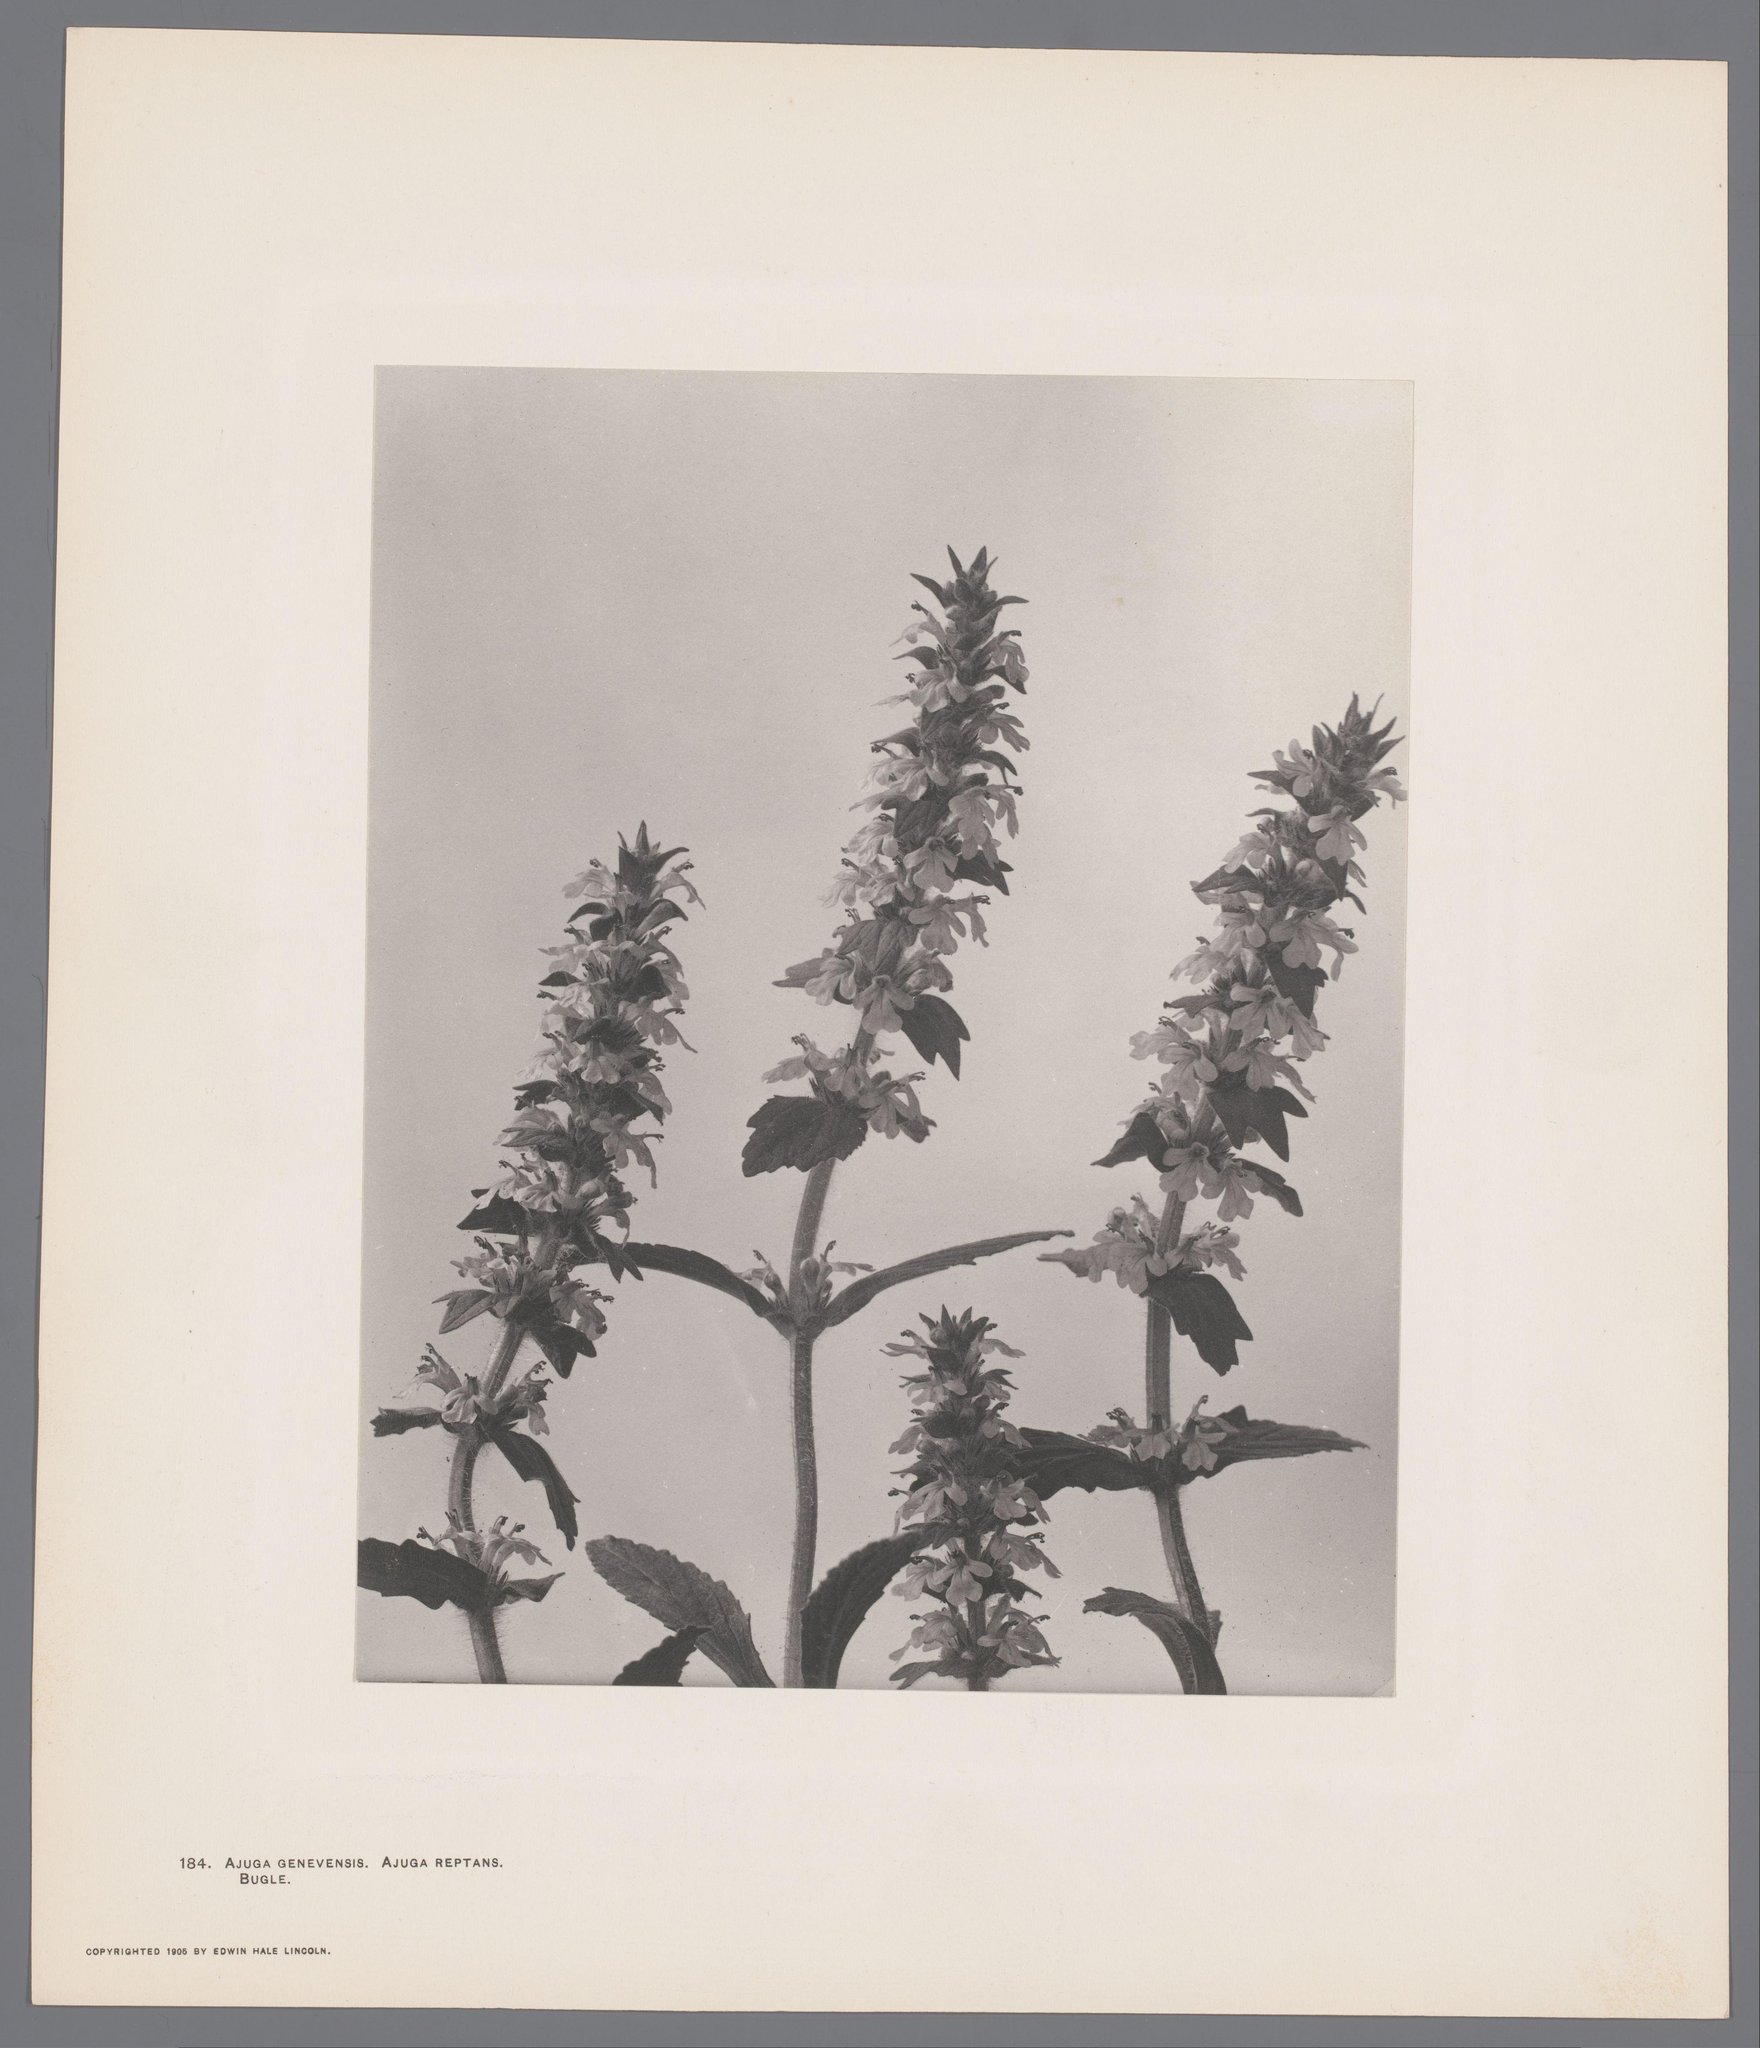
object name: photograph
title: Drie bloemstillevens uit Wild Flowers of New England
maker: edwin hale lincoln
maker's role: fotograaf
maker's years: 1848-1938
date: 1905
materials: paper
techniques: photography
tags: flowers